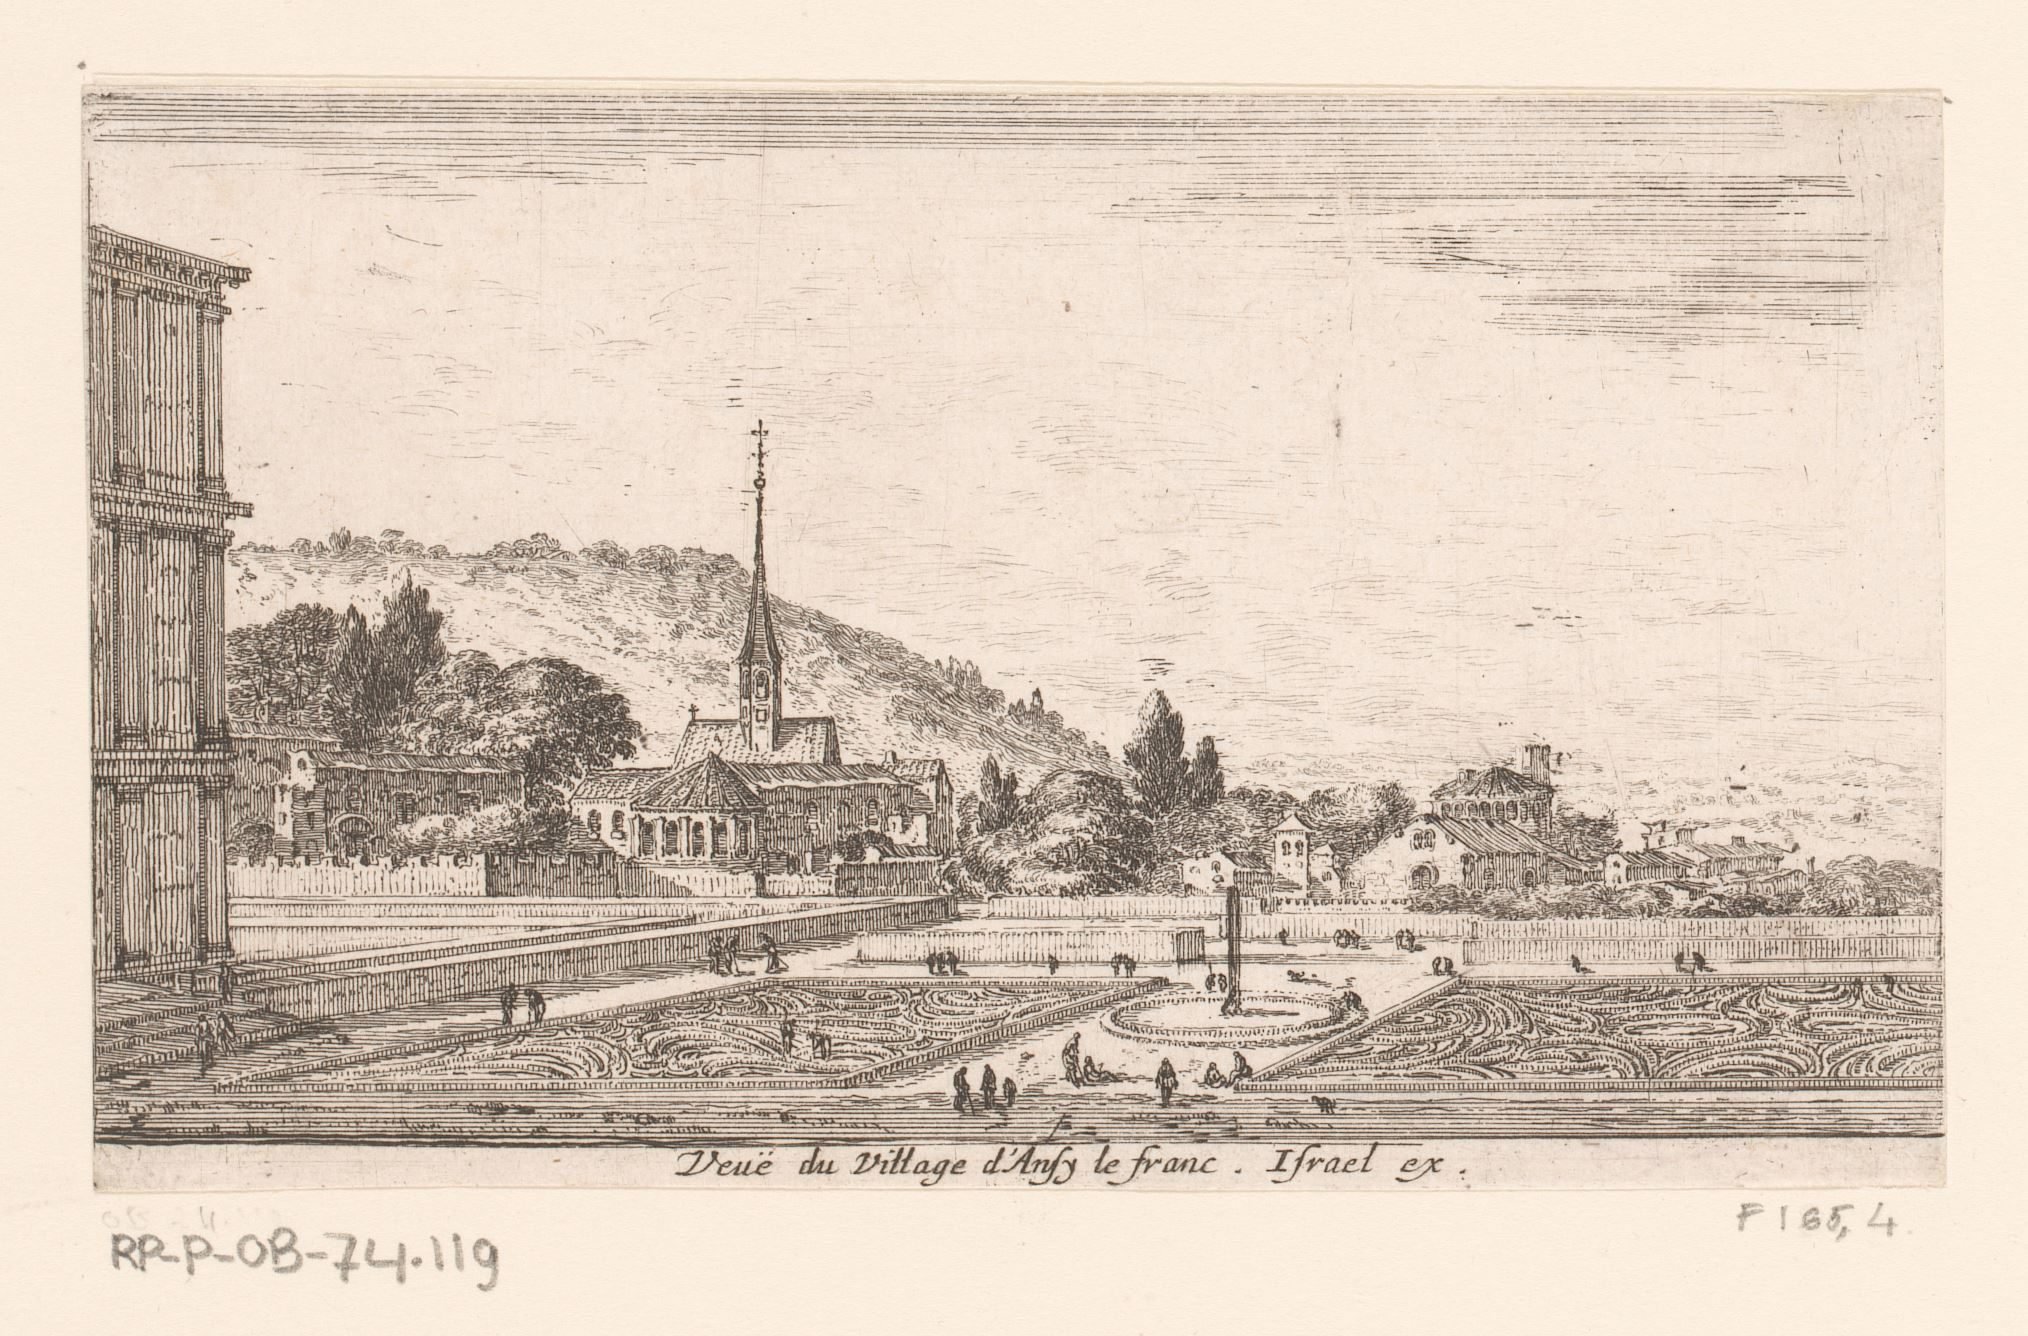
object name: print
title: Gezicht op het dorp Annecy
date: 1631-1661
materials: paper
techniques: etching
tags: french or architectonic garden; formal garden, landscape with tower or castle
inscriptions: collector's mark: Lugt 240